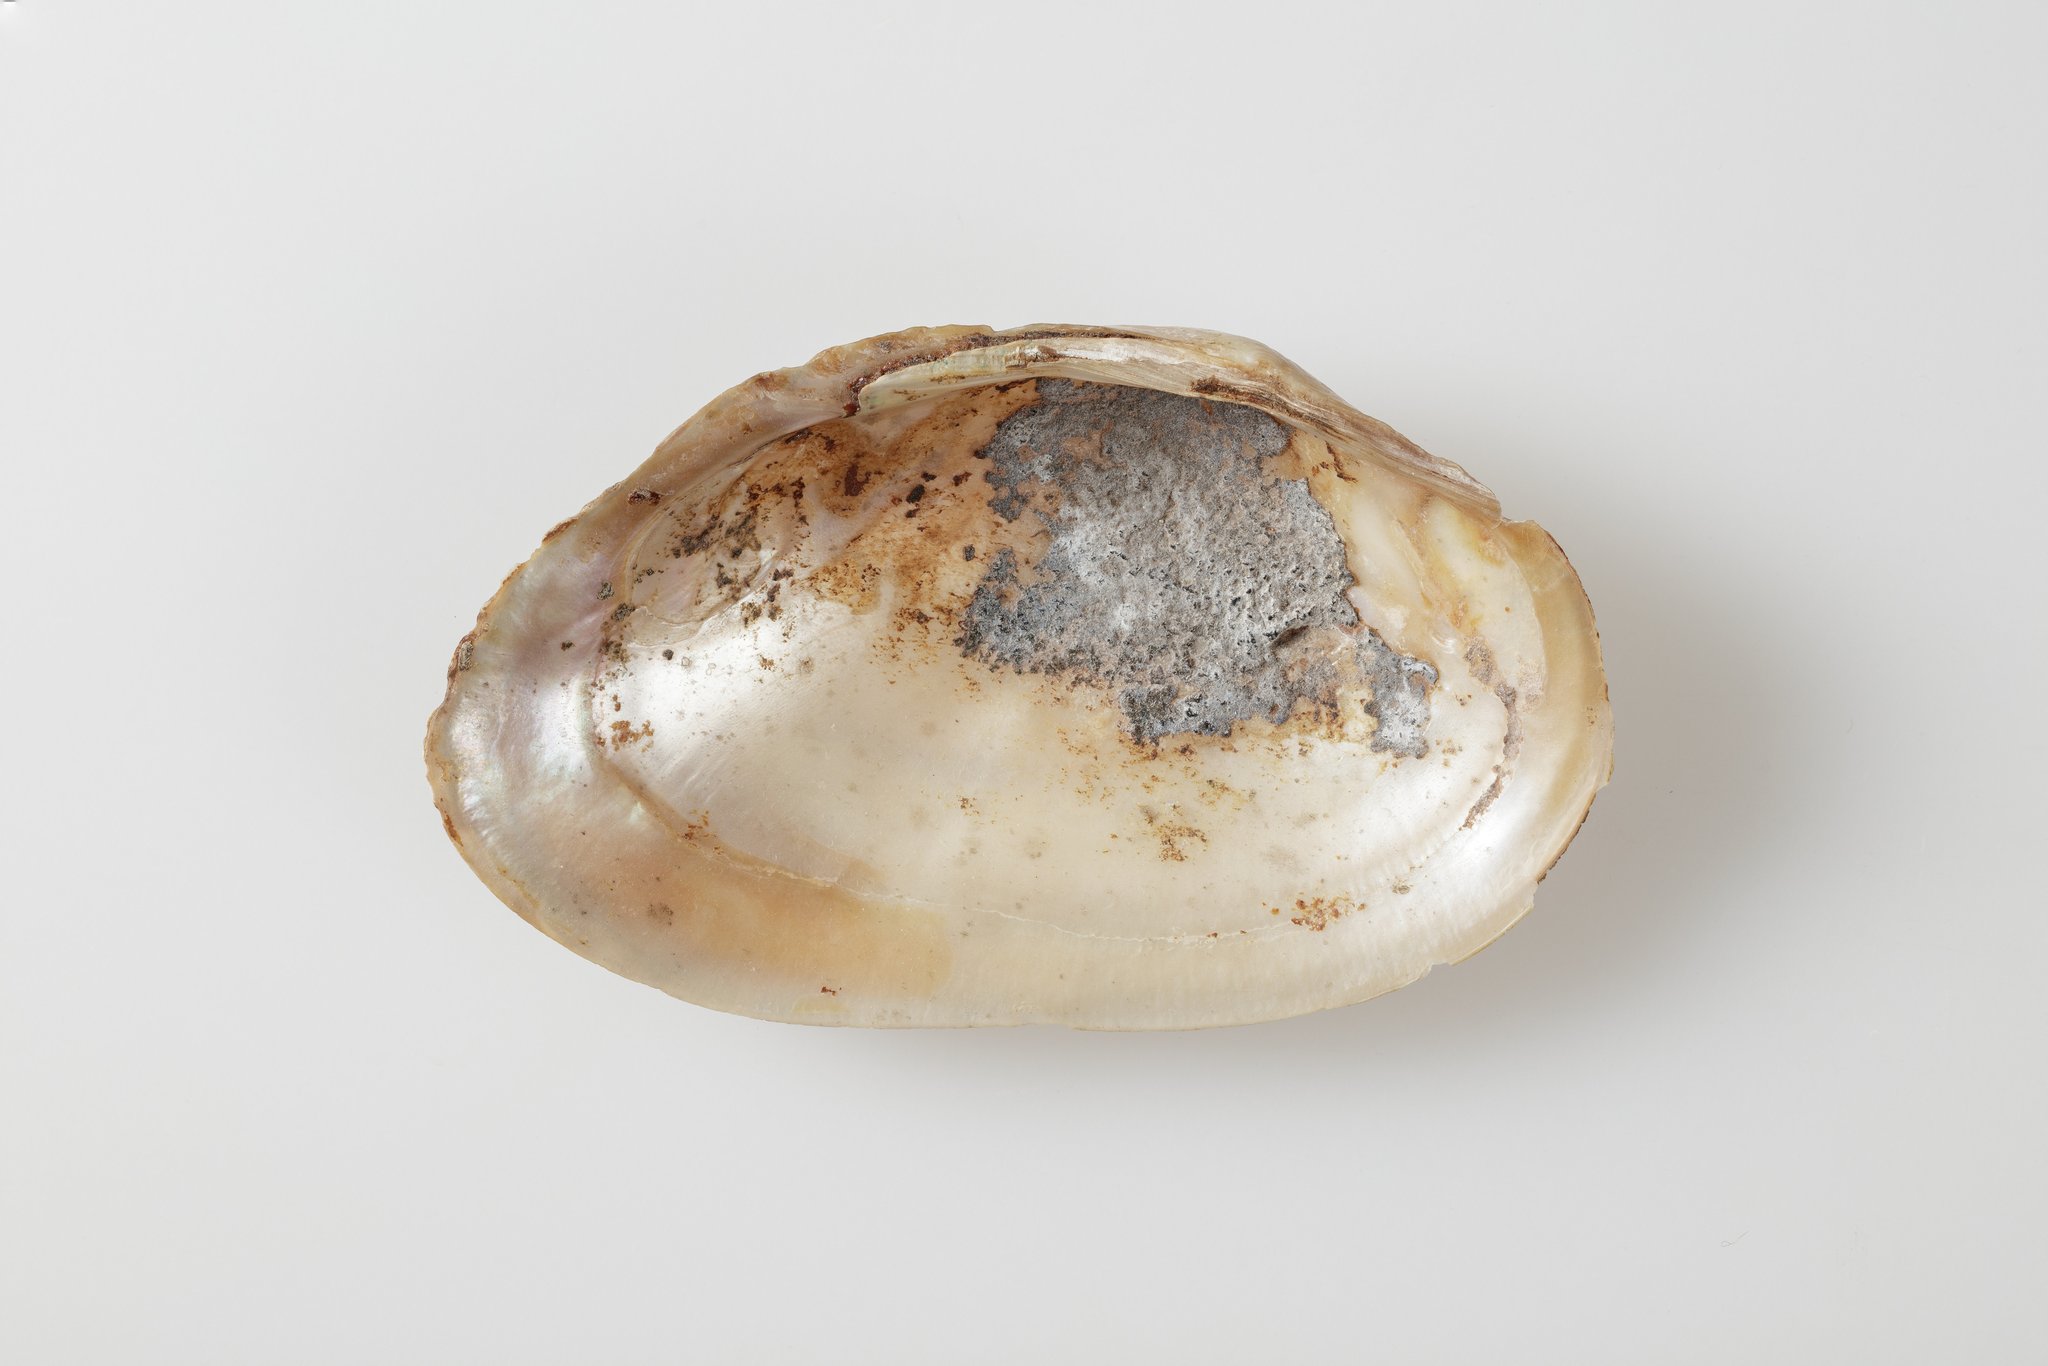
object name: clam shell, ink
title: Clam shell possibly used for ink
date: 664-332 BCE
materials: shell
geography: egypt